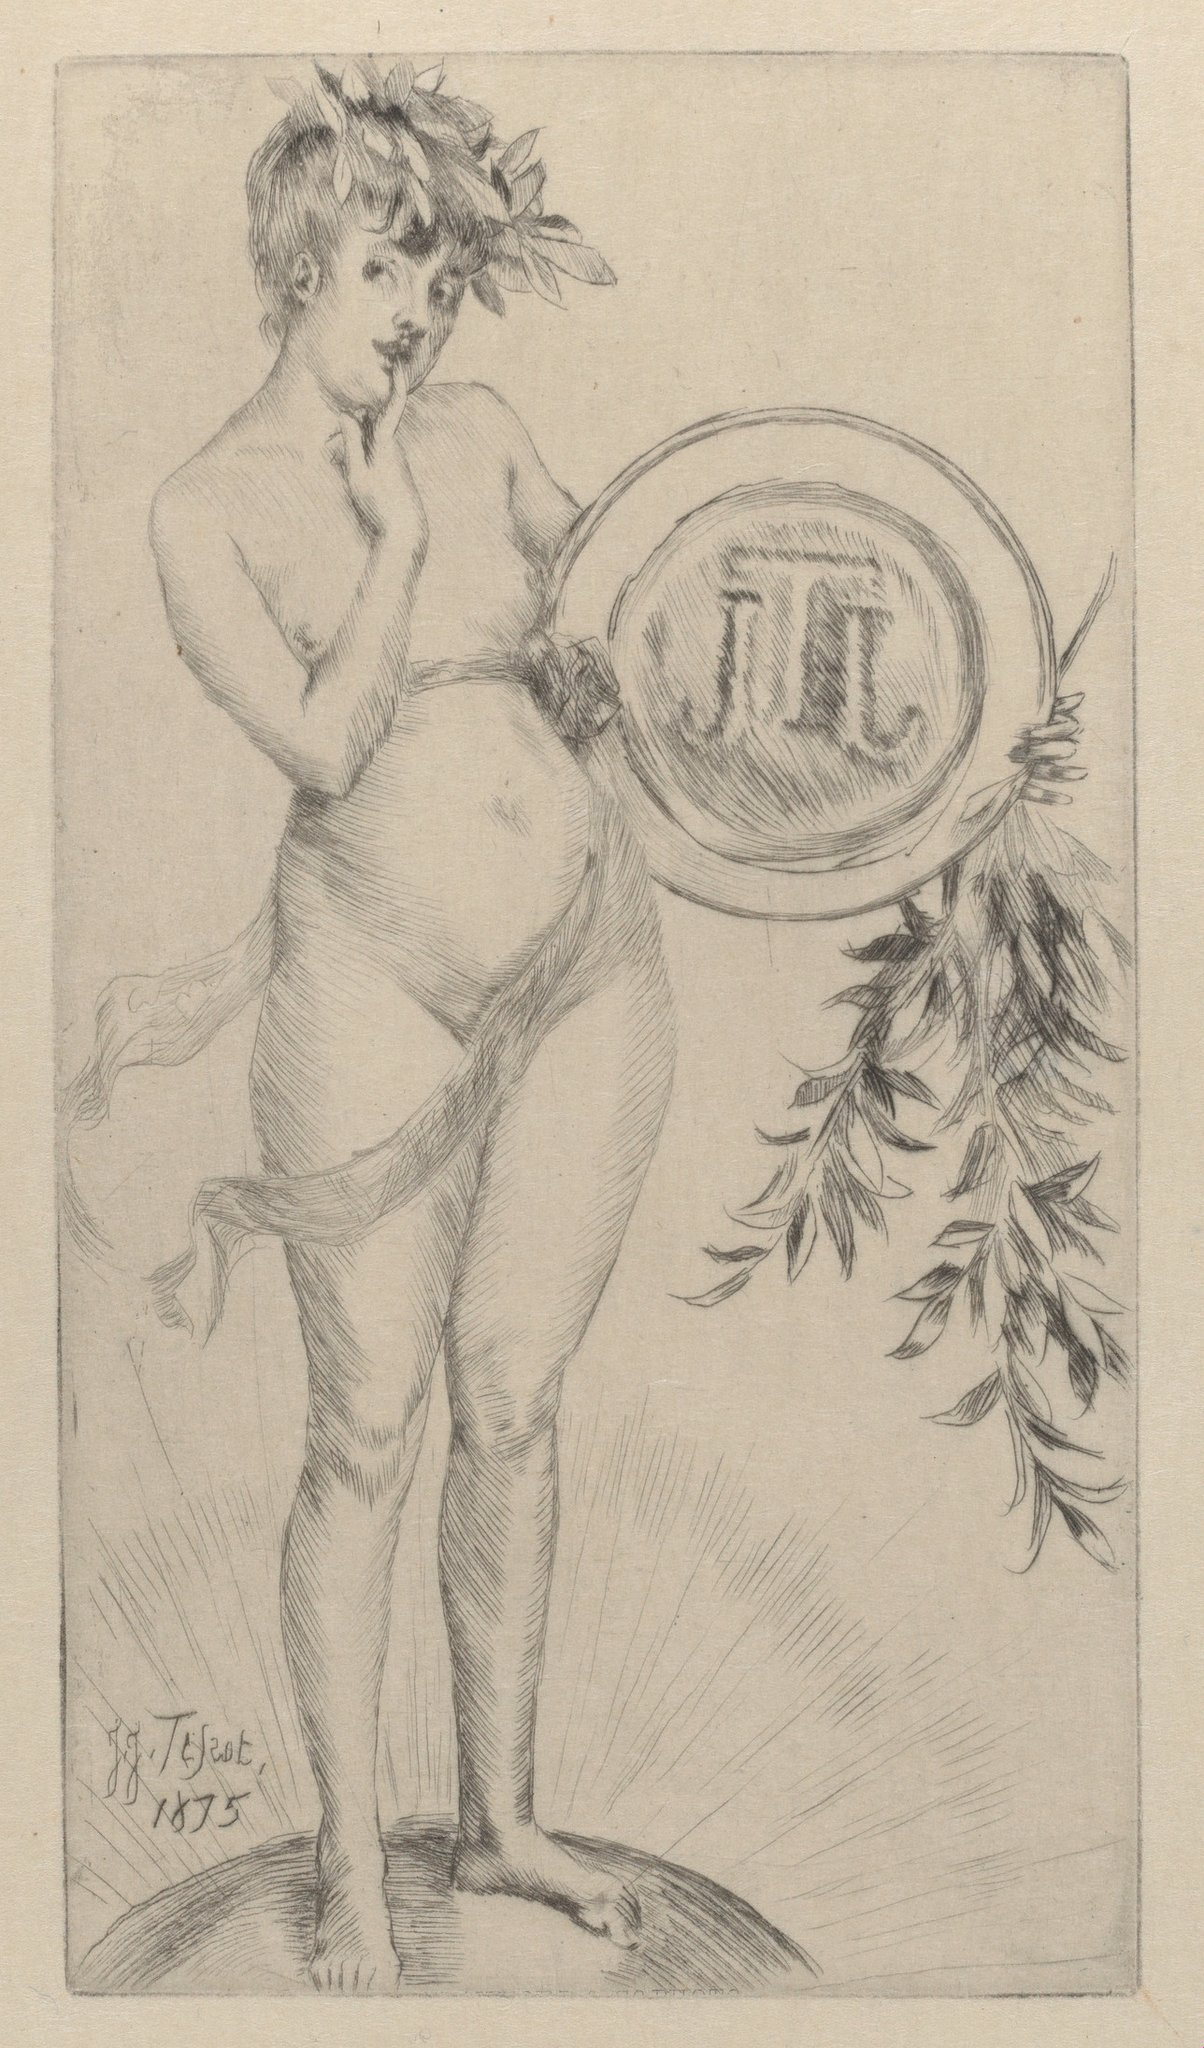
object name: print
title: First Frontispiece (with the Monogram)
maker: james tissot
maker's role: artist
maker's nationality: french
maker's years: 1836-1902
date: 1875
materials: paper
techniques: drypoint